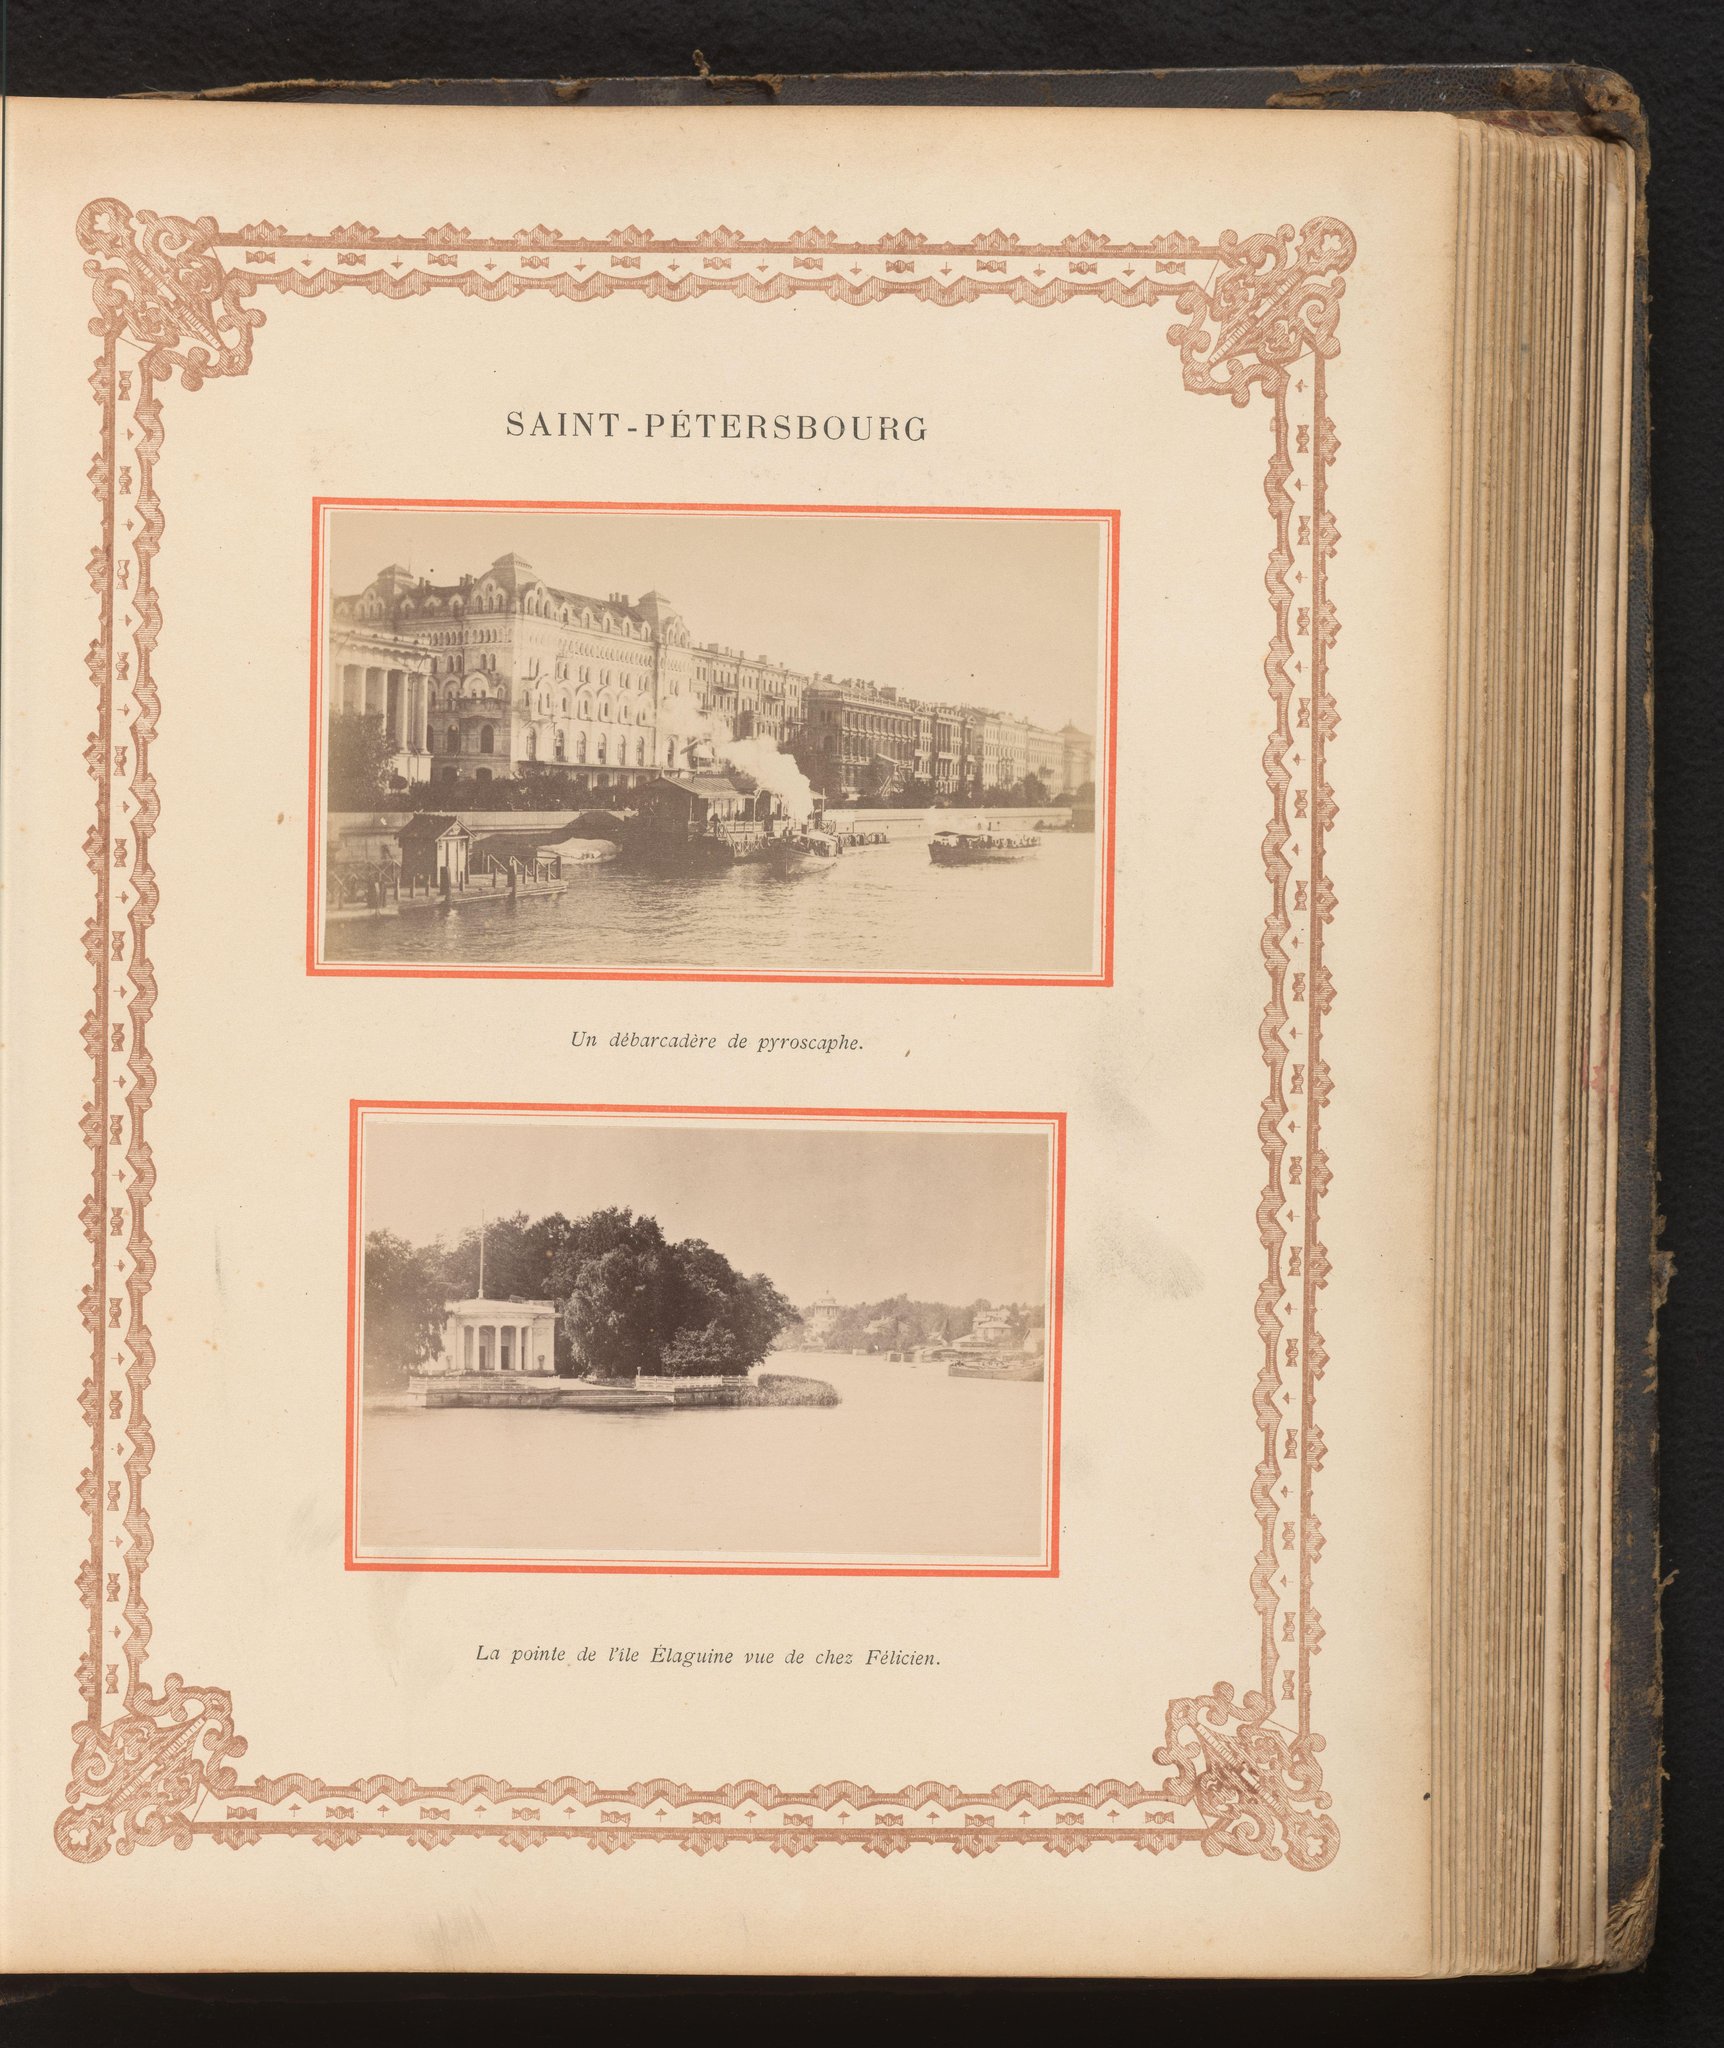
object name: photograph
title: La pointe de l'ile Élaguine vue de chez Félicien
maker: Anonymous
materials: photographic support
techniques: albumen print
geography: sint-petersburg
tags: island, pier, quay, wharf